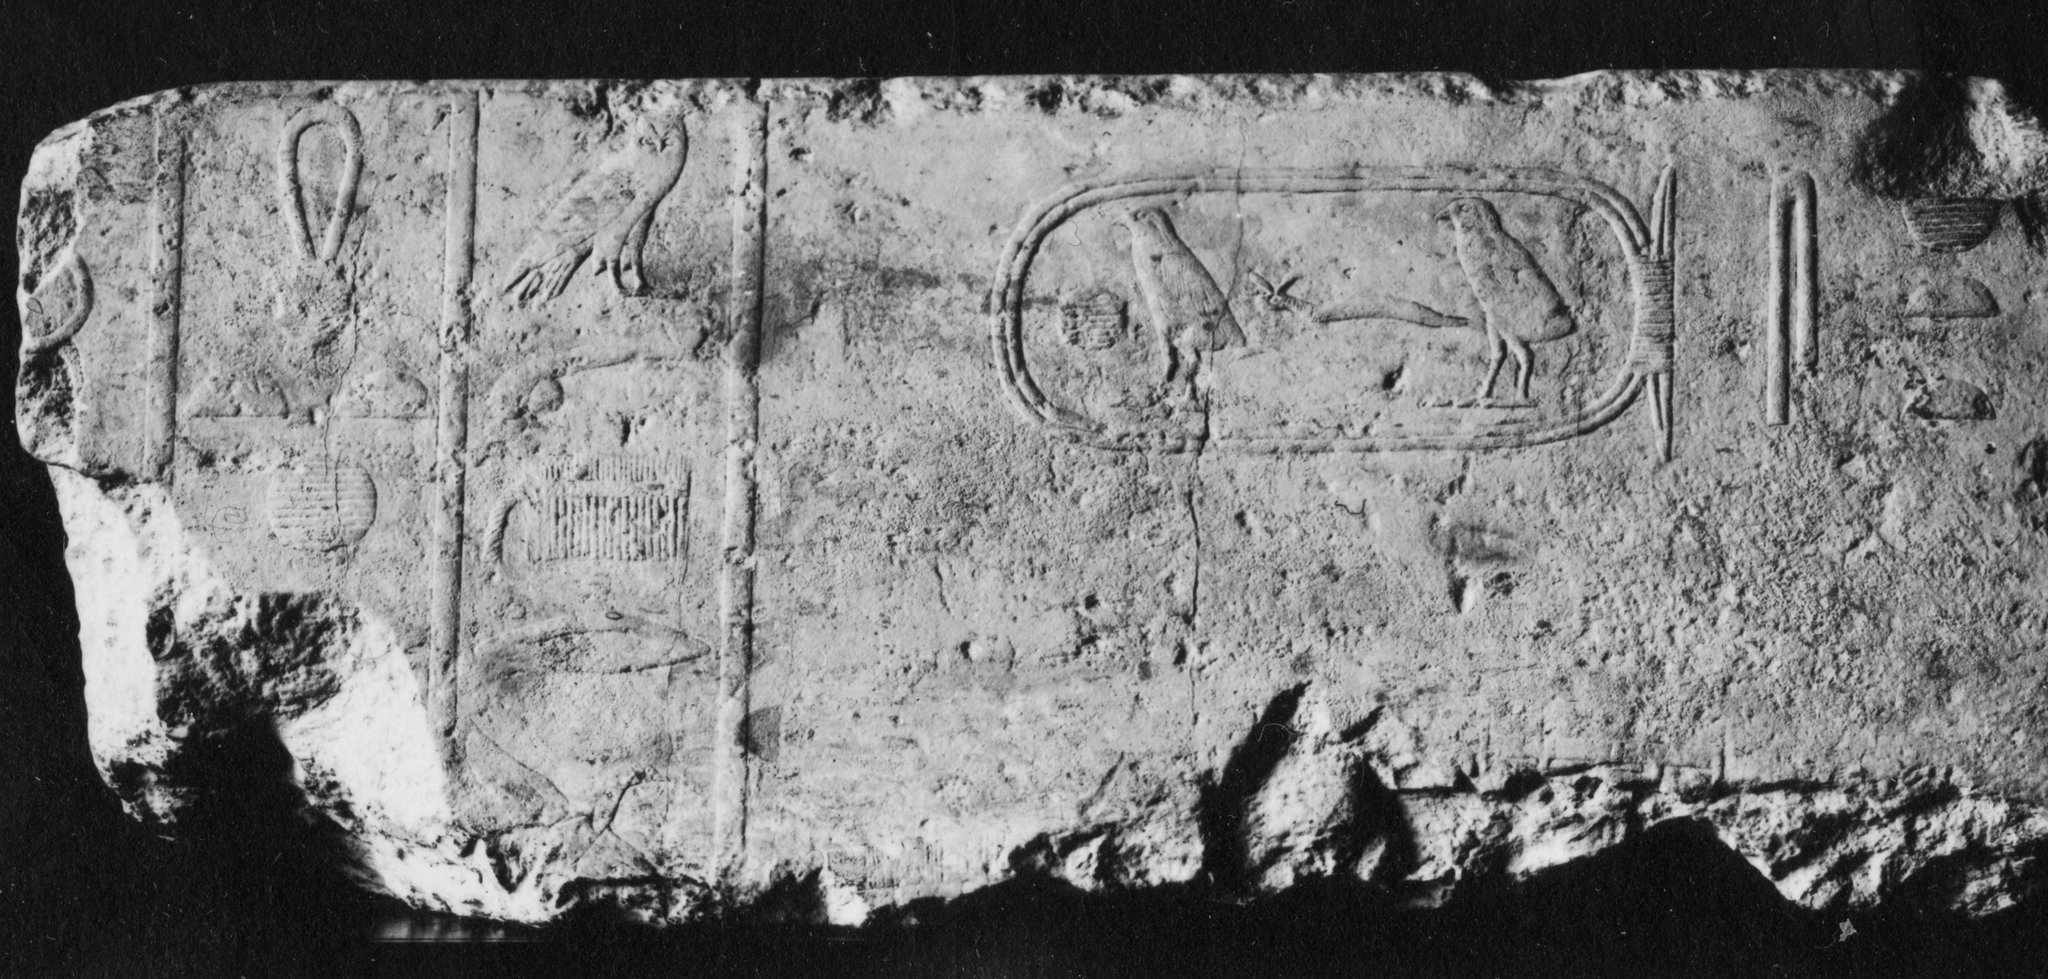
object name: relief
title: Block of Relief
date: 2551-2528 BCE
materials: limestone, paint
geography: egypt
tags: hieroglyphs